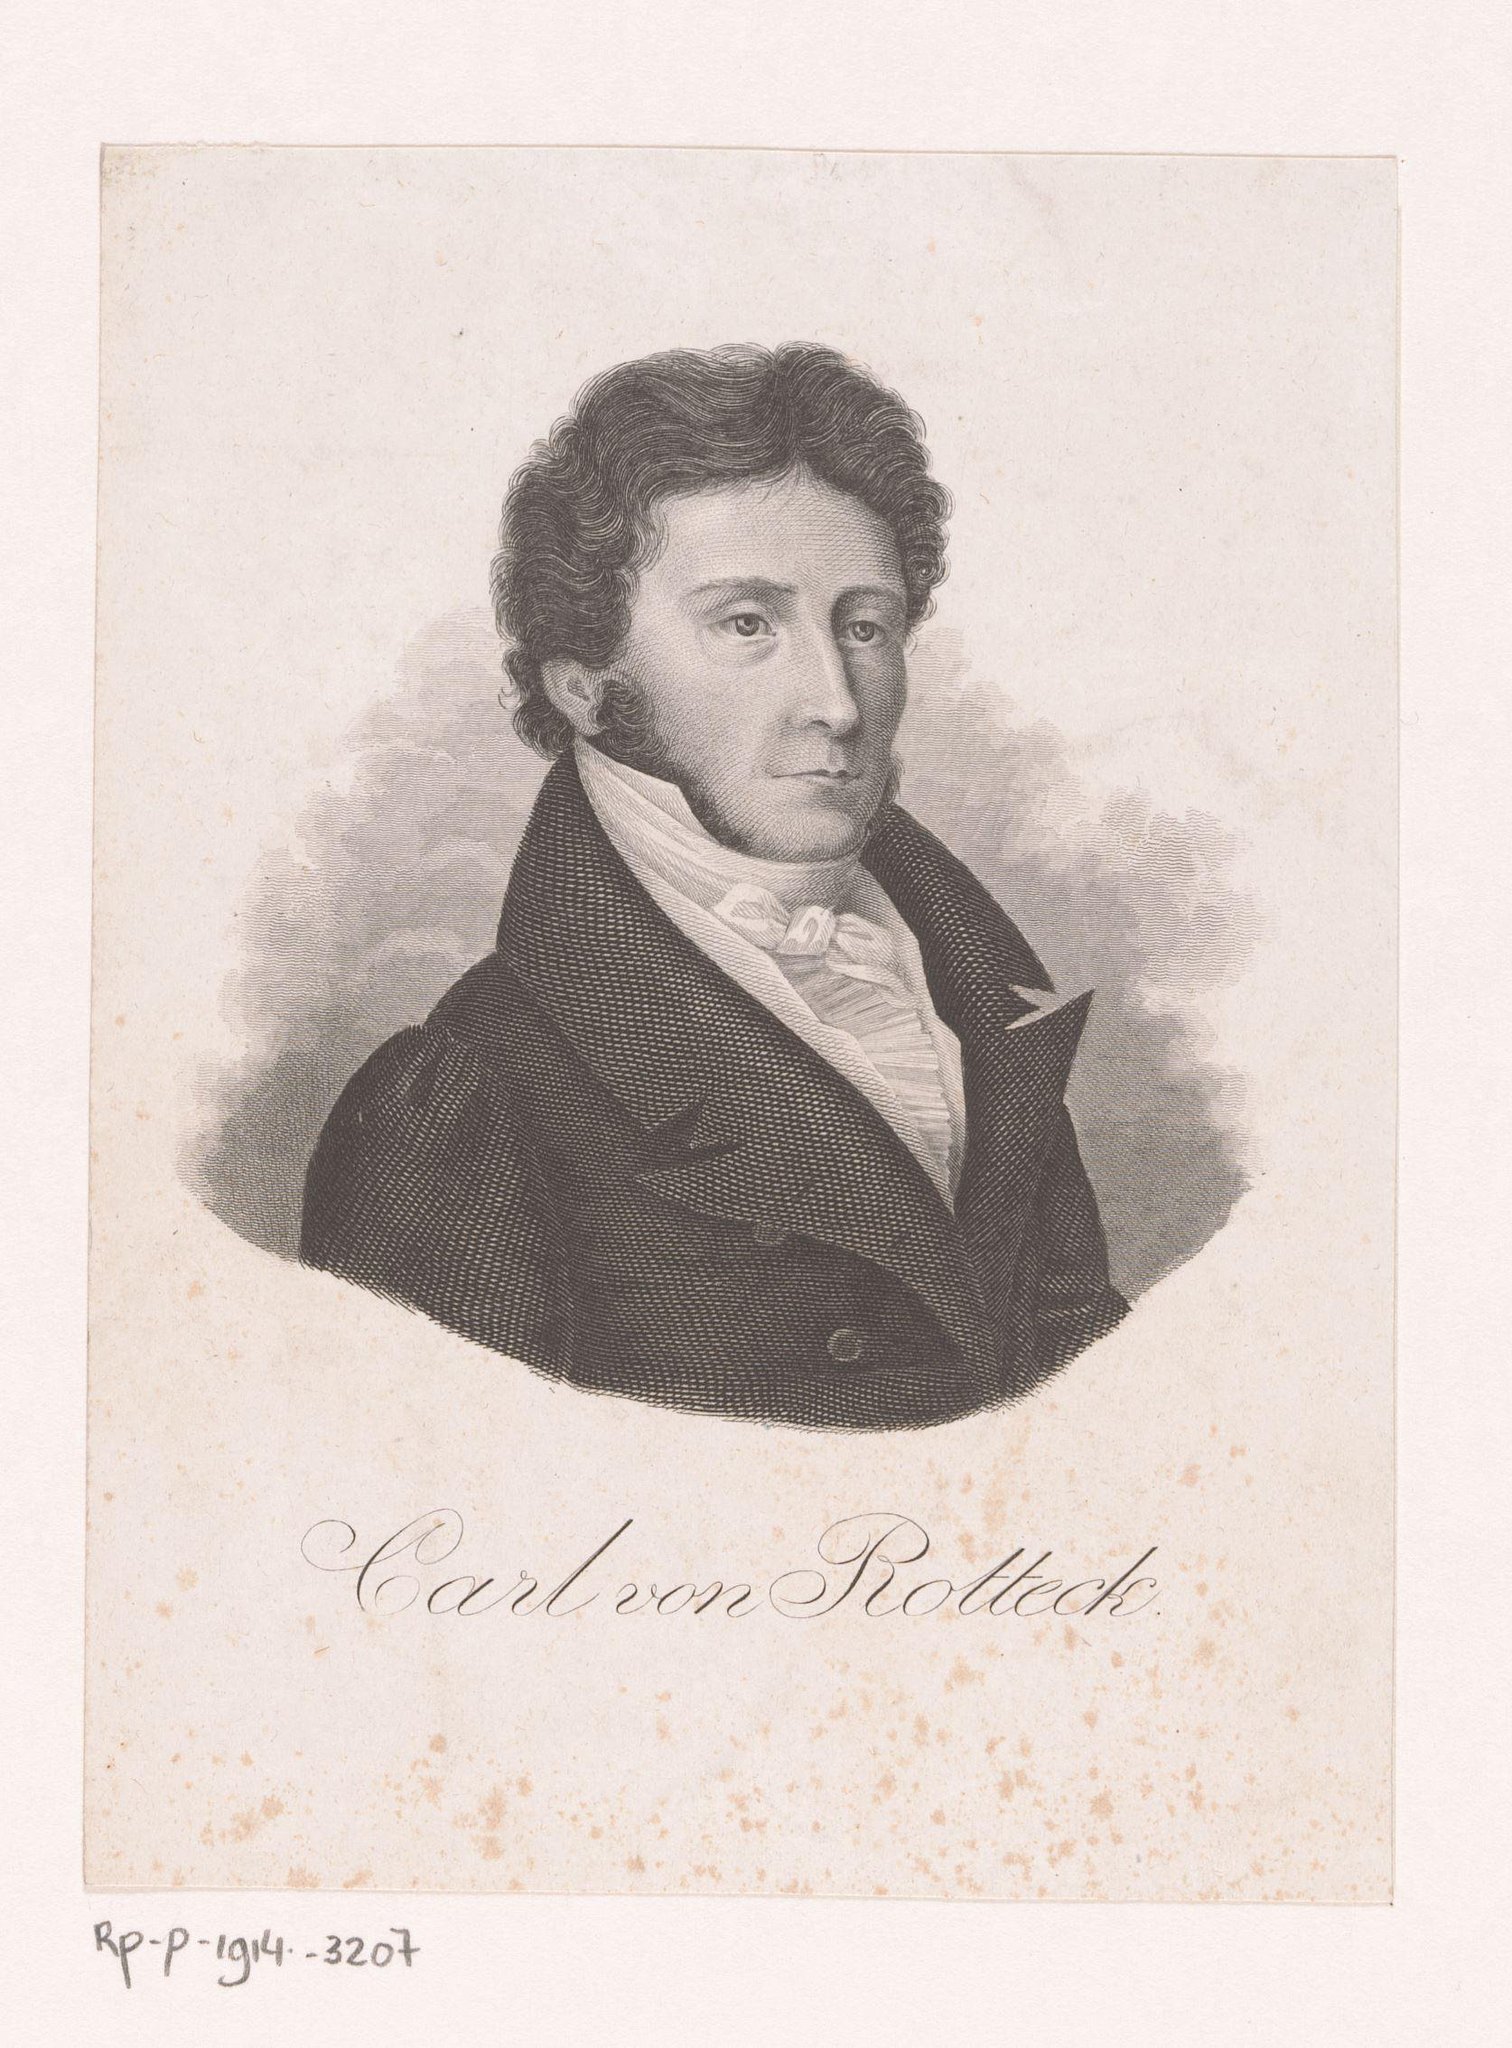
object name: print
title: Portret van Karl von Rotteck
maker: carl ludwig frommel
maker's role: print maker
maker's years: 1789-1863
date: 1799-1840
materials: paper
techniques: engraving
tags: historical persons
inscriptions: collector's mark: Lugt 2228